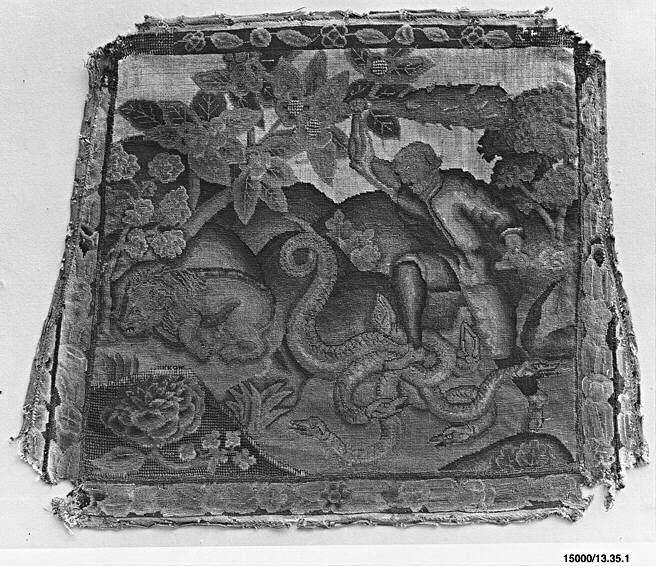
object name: cover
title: Chair seat cover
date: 1701-1800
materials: silk, wool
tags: men,lions,serpents,flowers,leaves